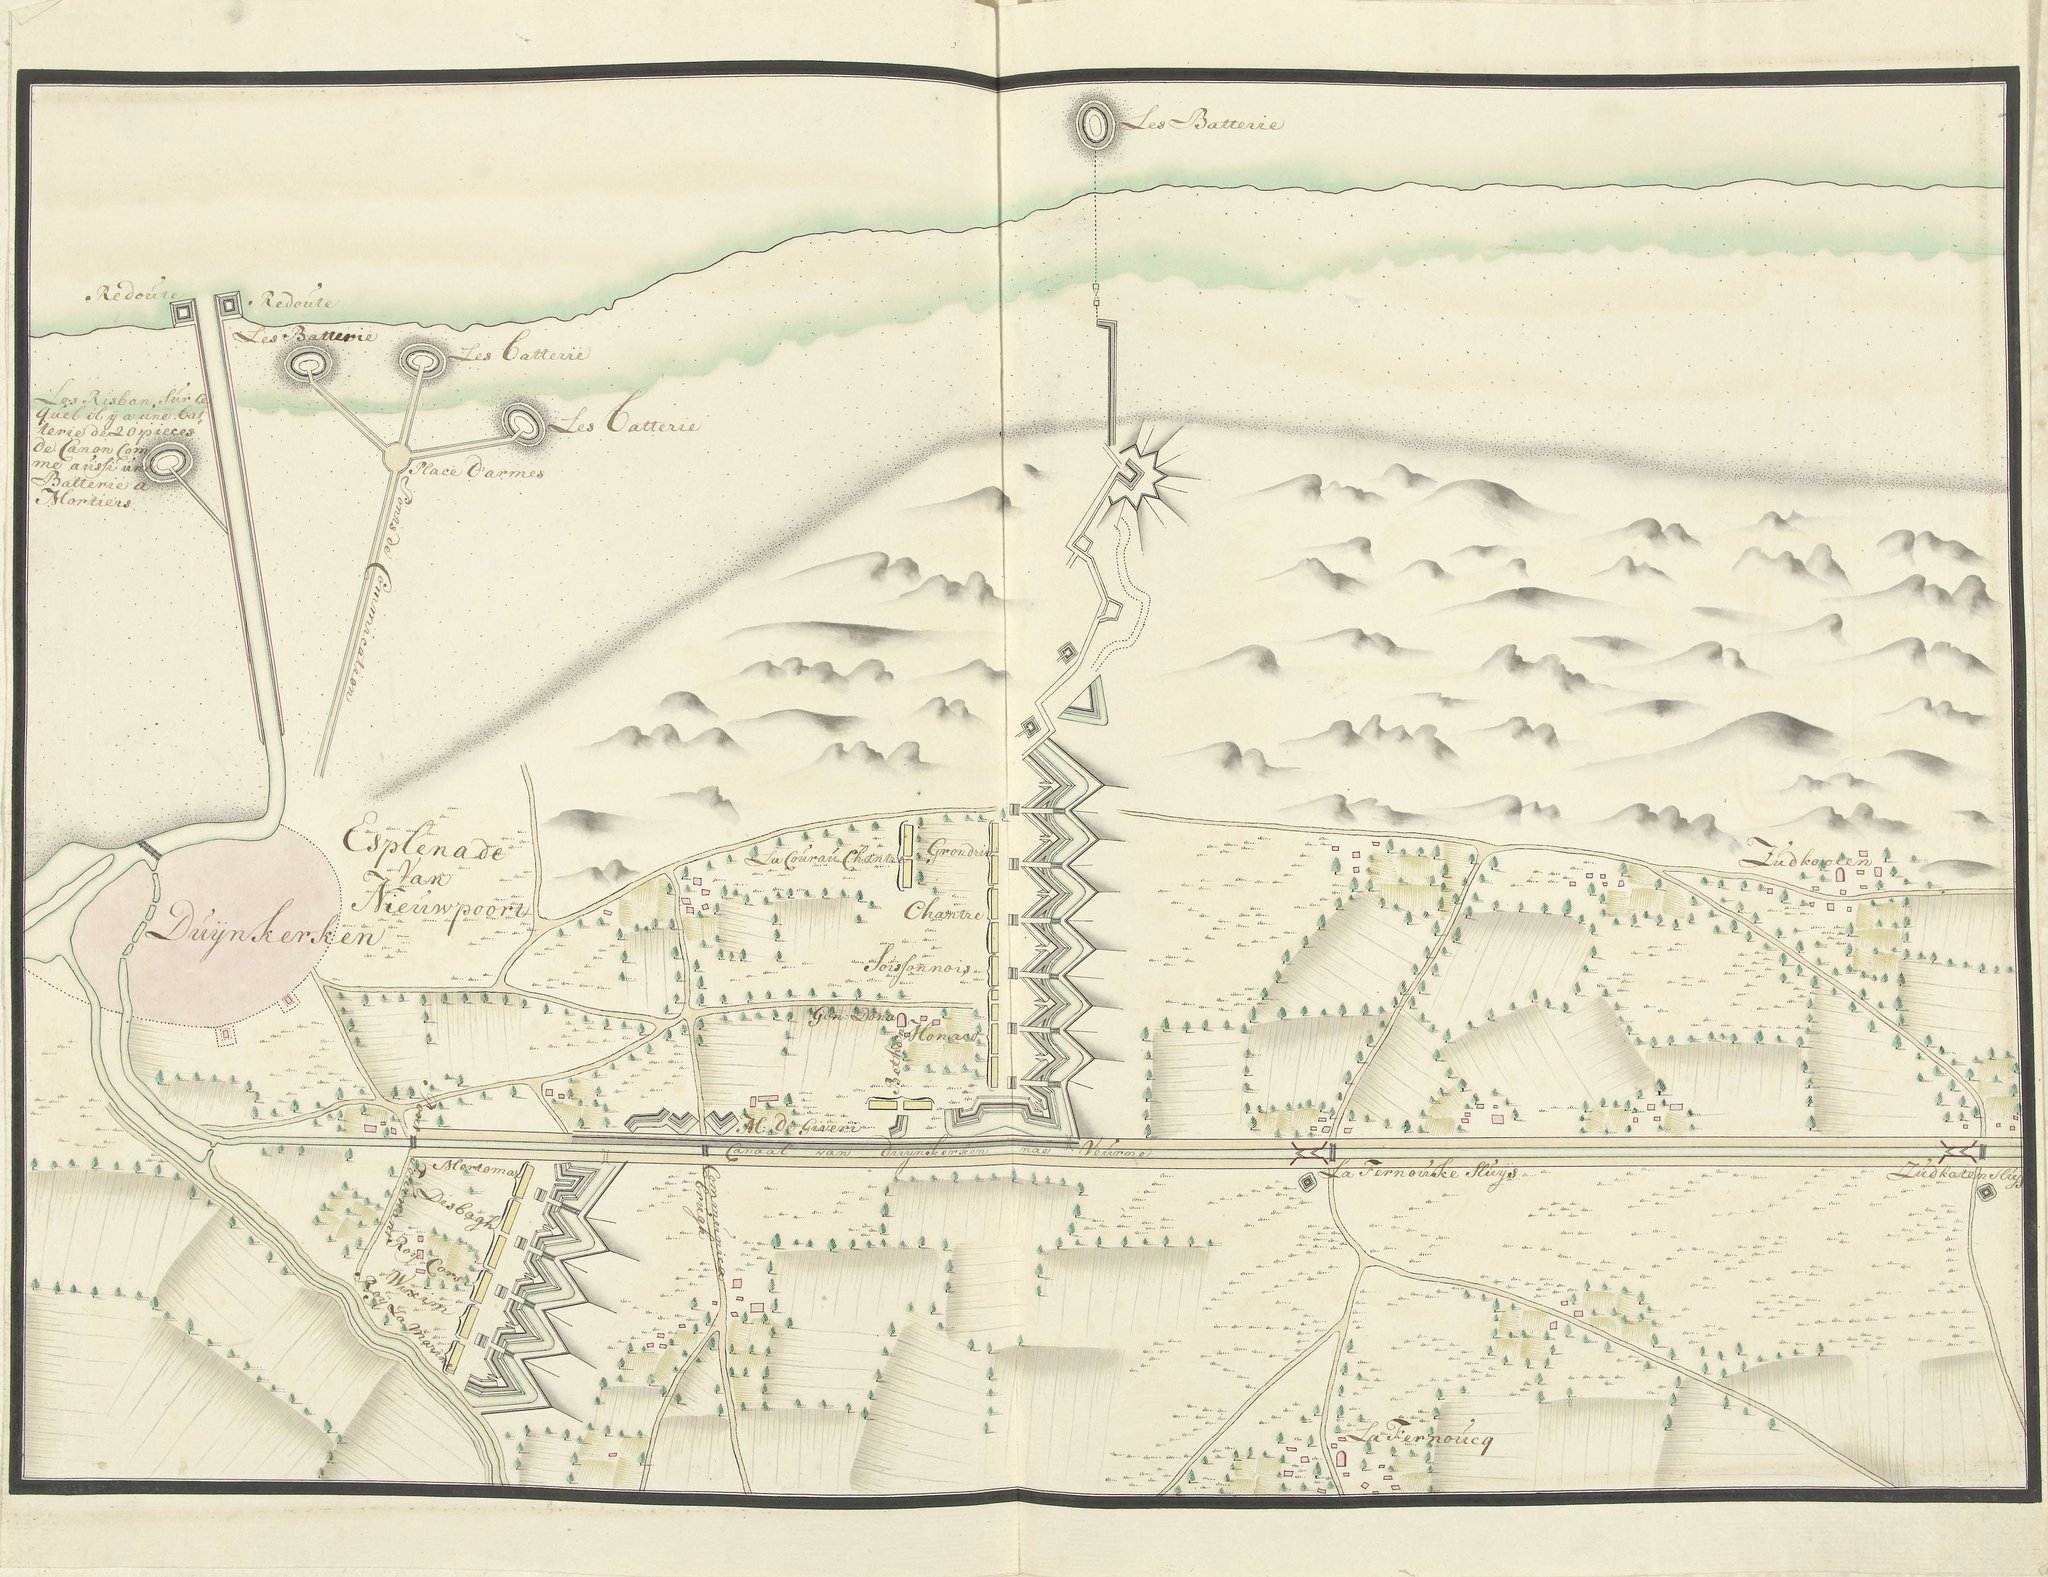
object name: map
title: Plattegrond van de schansen ten noorden van Duinkerke, ca. 1701-1715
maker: samuel du ry de champdoré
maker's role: draughtsman, engineer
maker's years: 1651-1729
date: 1706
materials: paper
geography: netherlands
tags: fortress, maps of separate countries or regions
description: Plattegrond van de schansen ten noorden van de stad Duinkerke, ca. 1701-1715. Onderdeel van een verzameling getekende plannen van versterkte plaatsen in Nederland en omringende landen ten tijde van de Spaanse Successieoorlog (deel C).